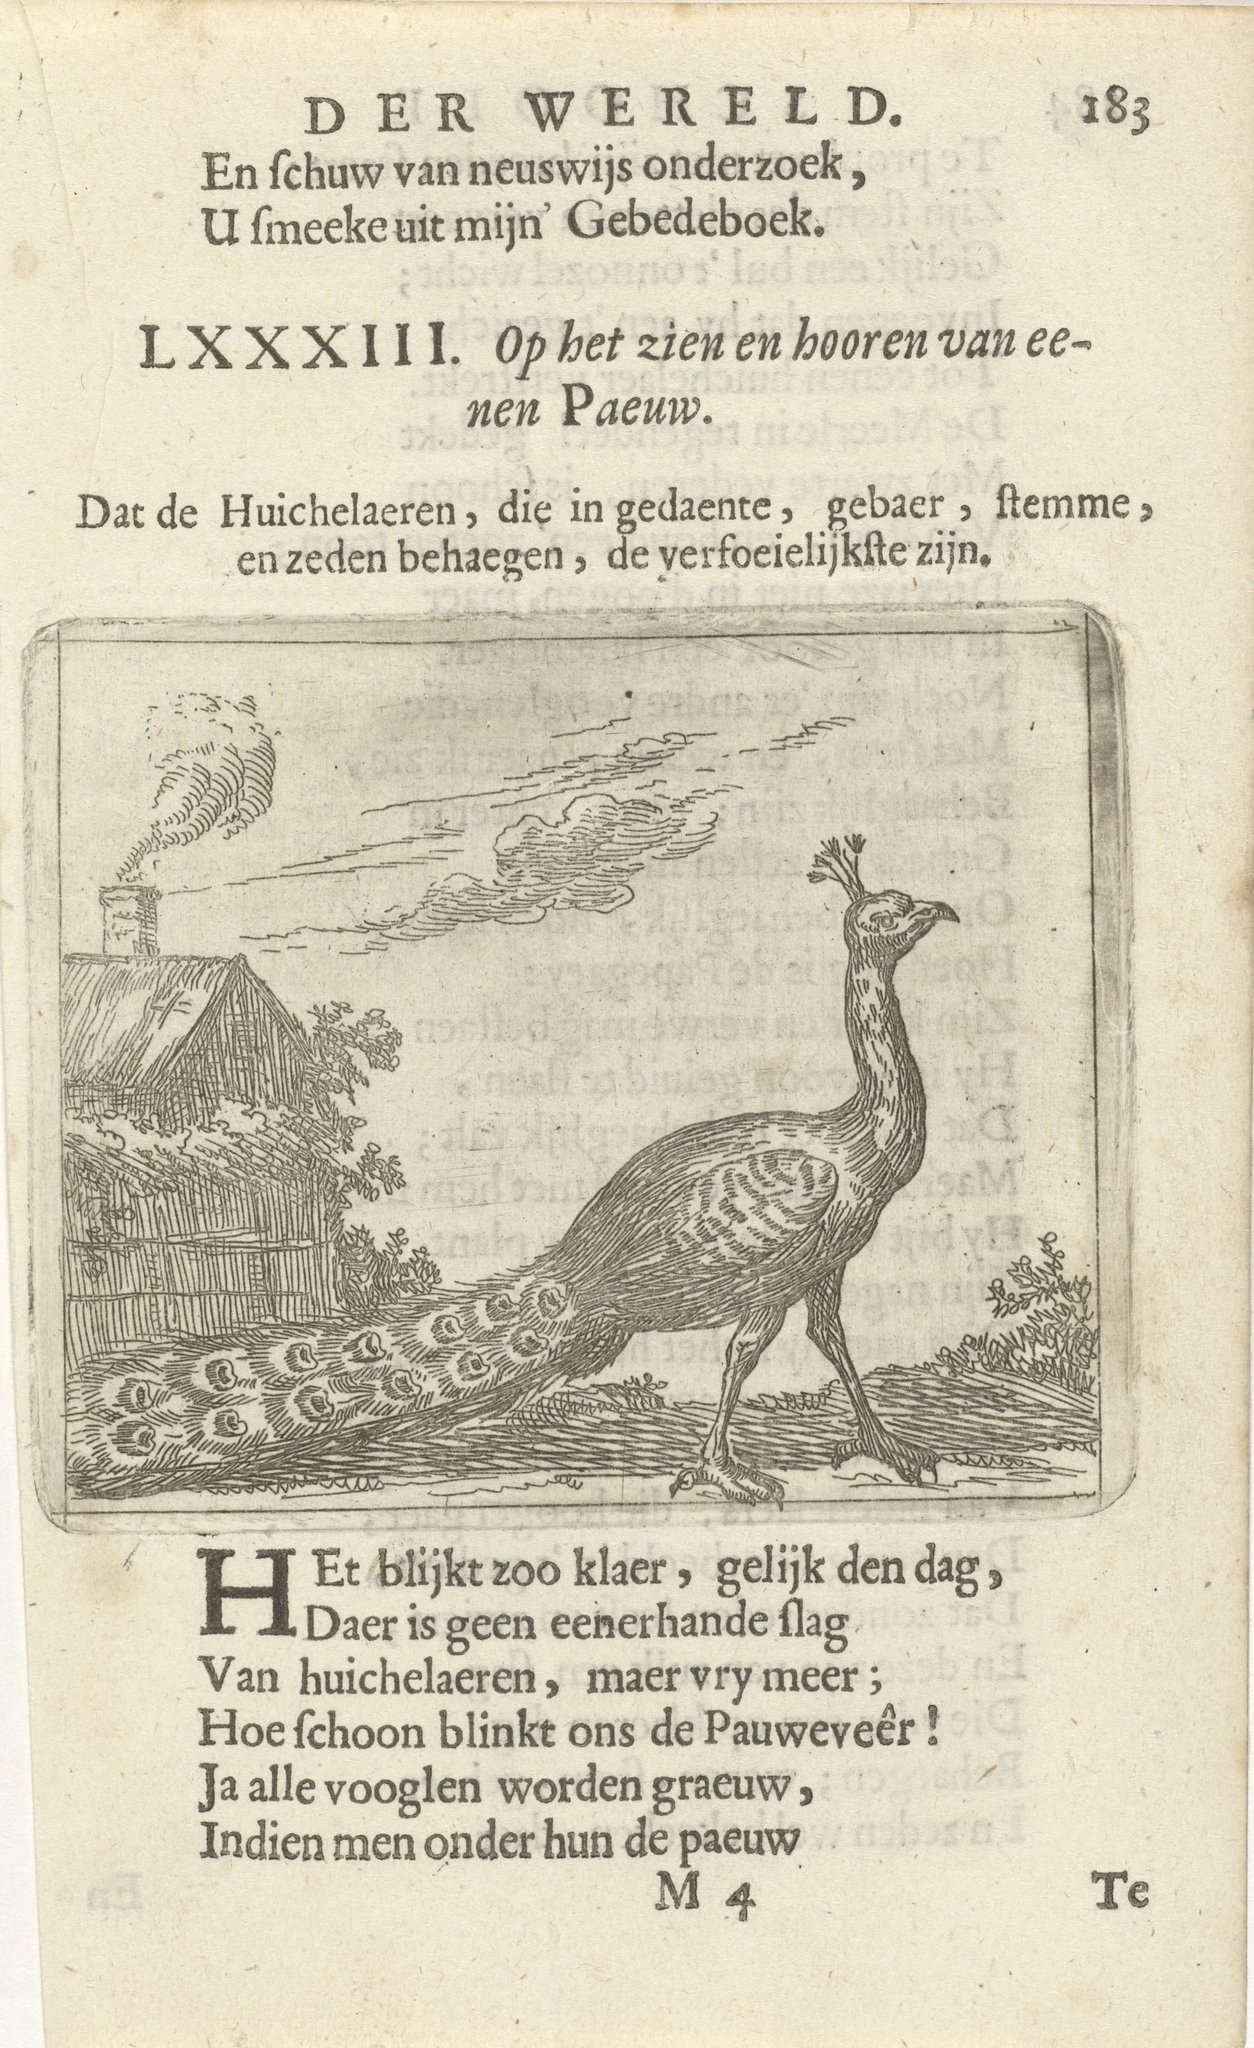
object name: print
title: LXXXIII. Op het zien en hooren van eenen Paeuw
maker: arnold houbraken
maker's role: draughtsman, painter, print maker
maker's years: 1660-1719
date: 1682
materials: paper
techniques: etching, letterpress printing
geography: northern netherlands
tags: ornamental birds: peacock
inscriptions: collector's mark: Lugt 2228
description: Prent uit: Joseph Hall, [bewerkt door] François van Hoogstraeten, De schoole der wereld, geopent in CXL. vliegende bedenkingen op veelerhande voorvallende gezichten en zaeken. Dordrecht: François van Hoogstraeten, 1682. En in herdrukken in 1687 en 1725.